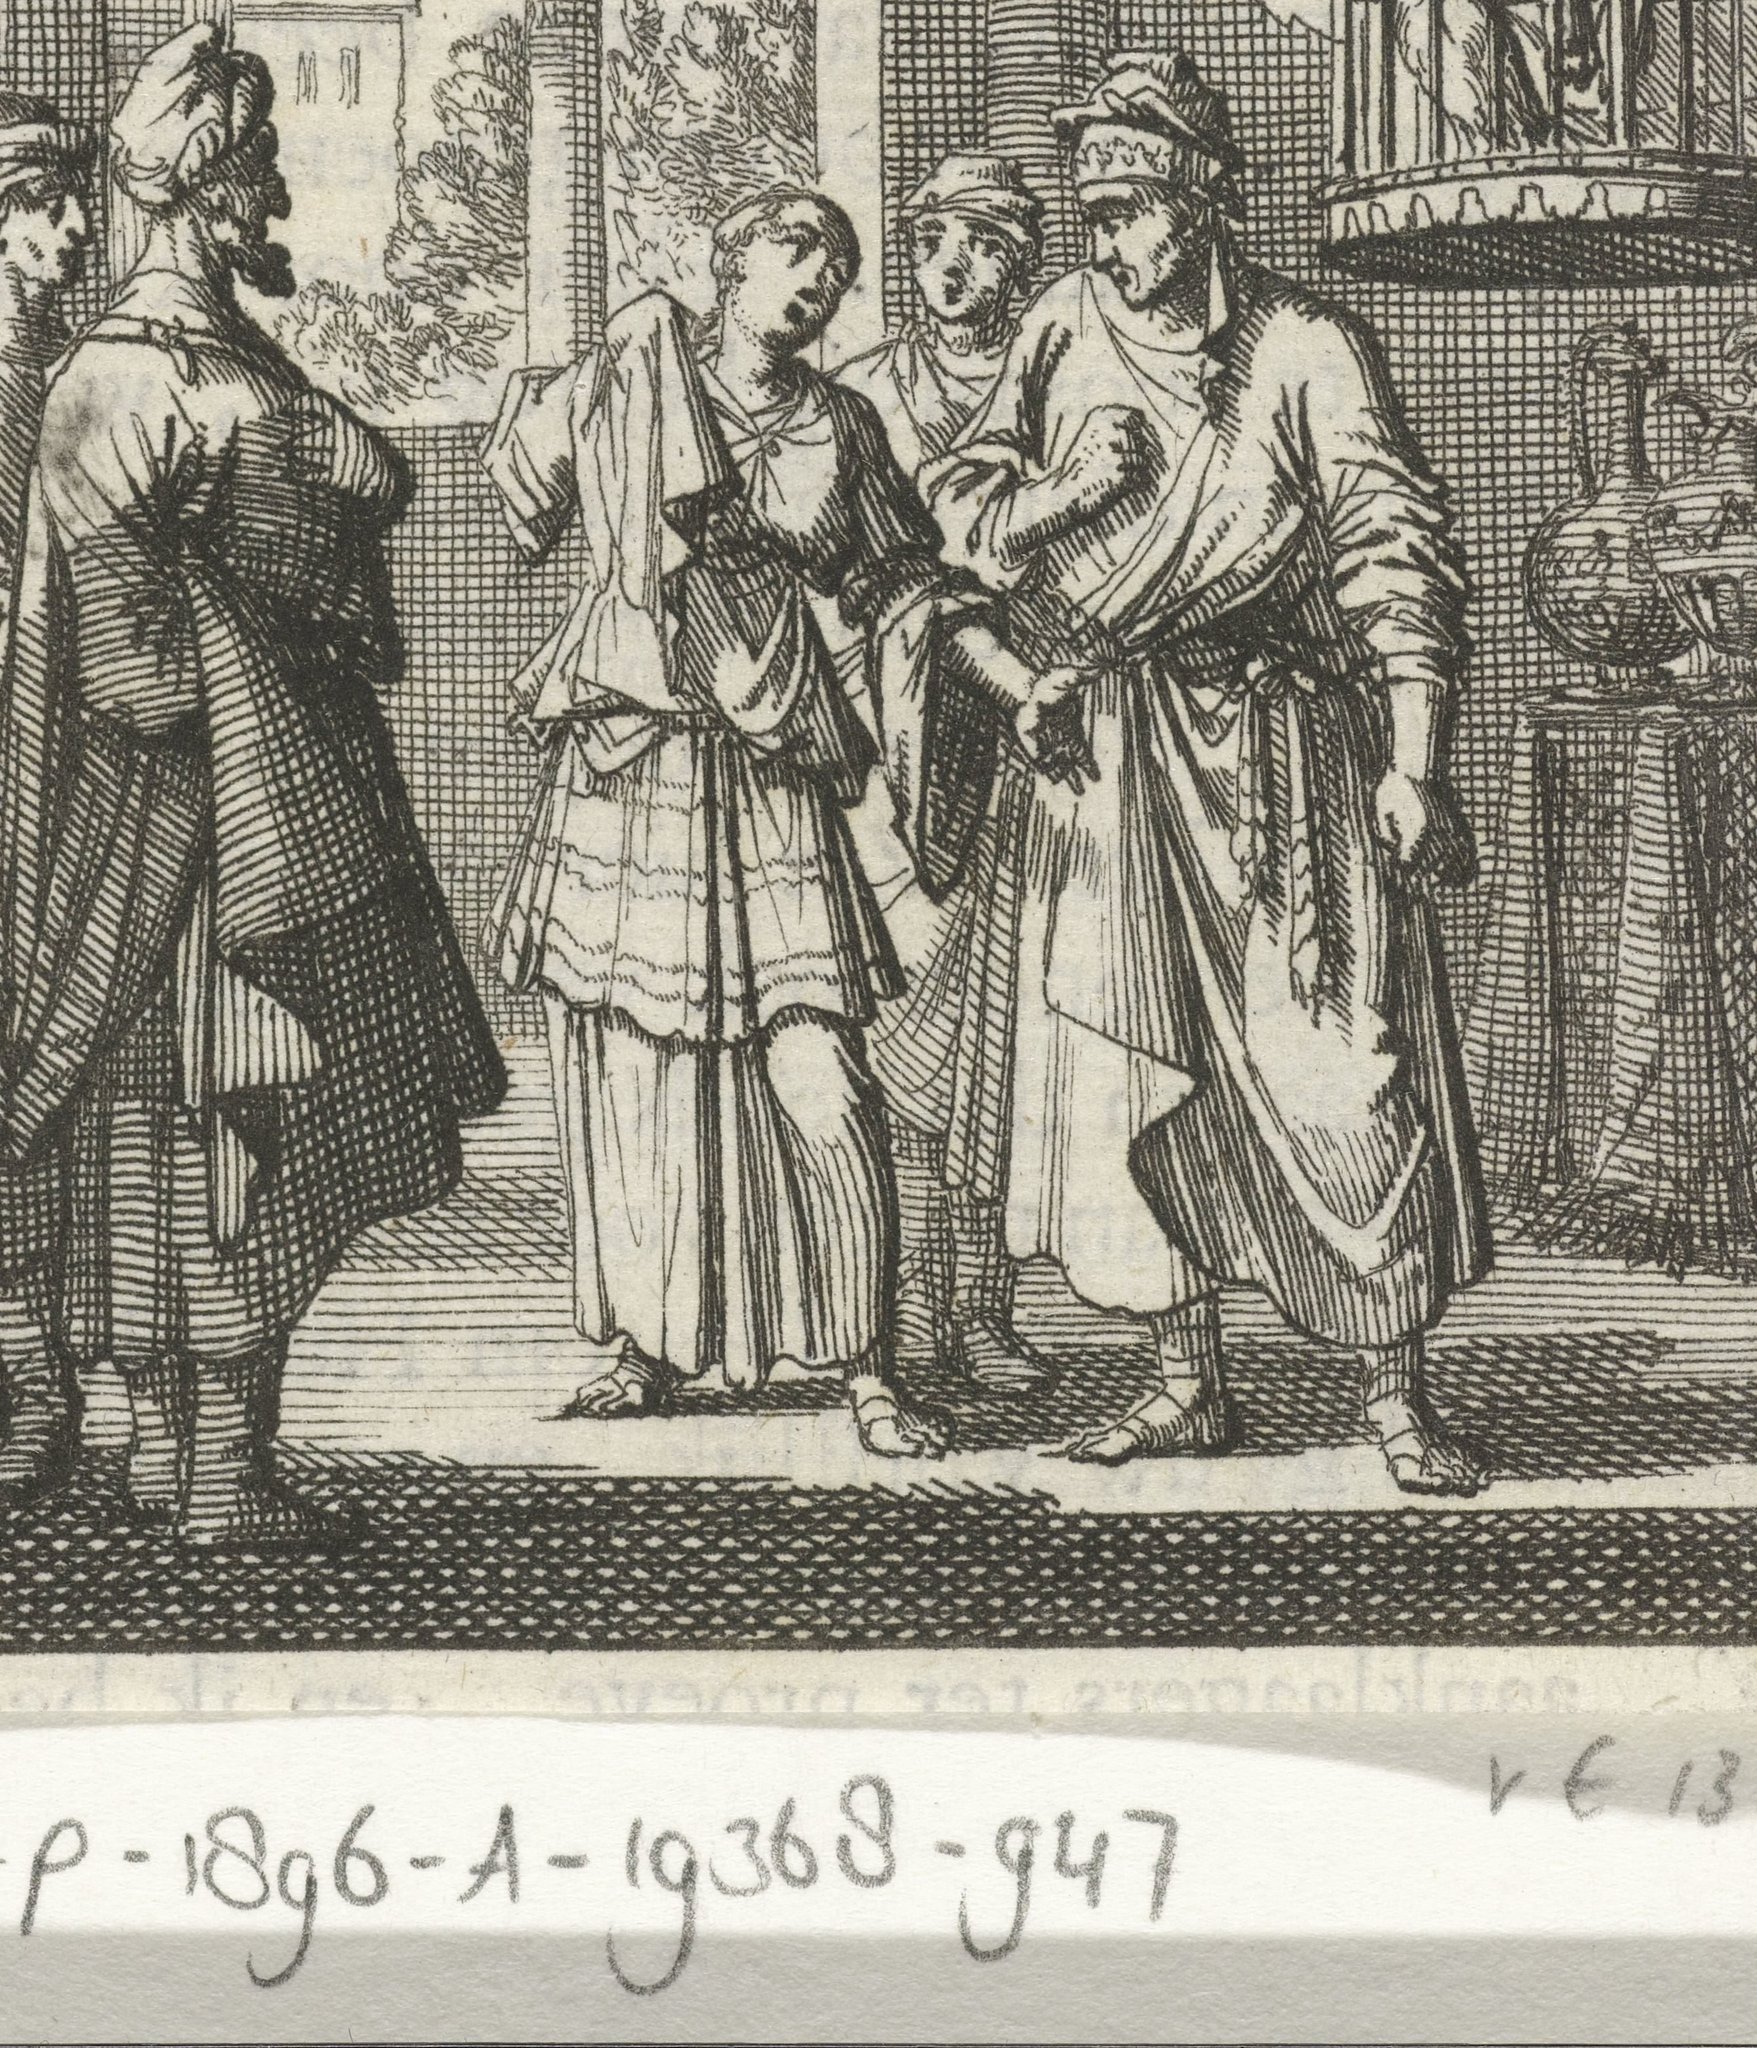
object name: print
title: Man spreekt zijn wenende huisvrouw toe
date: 1693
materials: paper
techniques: etching, letterpress printing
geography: amsterdam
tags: marriage, married couple, 'matrimonium', crying, shouting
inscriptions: collector's mark: Lugt 2228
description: Illustratie uit: Duĳkerius, Johannes. Voorbeeldzels der oude wyzen. Waar in (...) de menschelijke hartstogten (...) behandeld worden. Amsterdam: Aart Wolsgrein, 1693, p. 207.